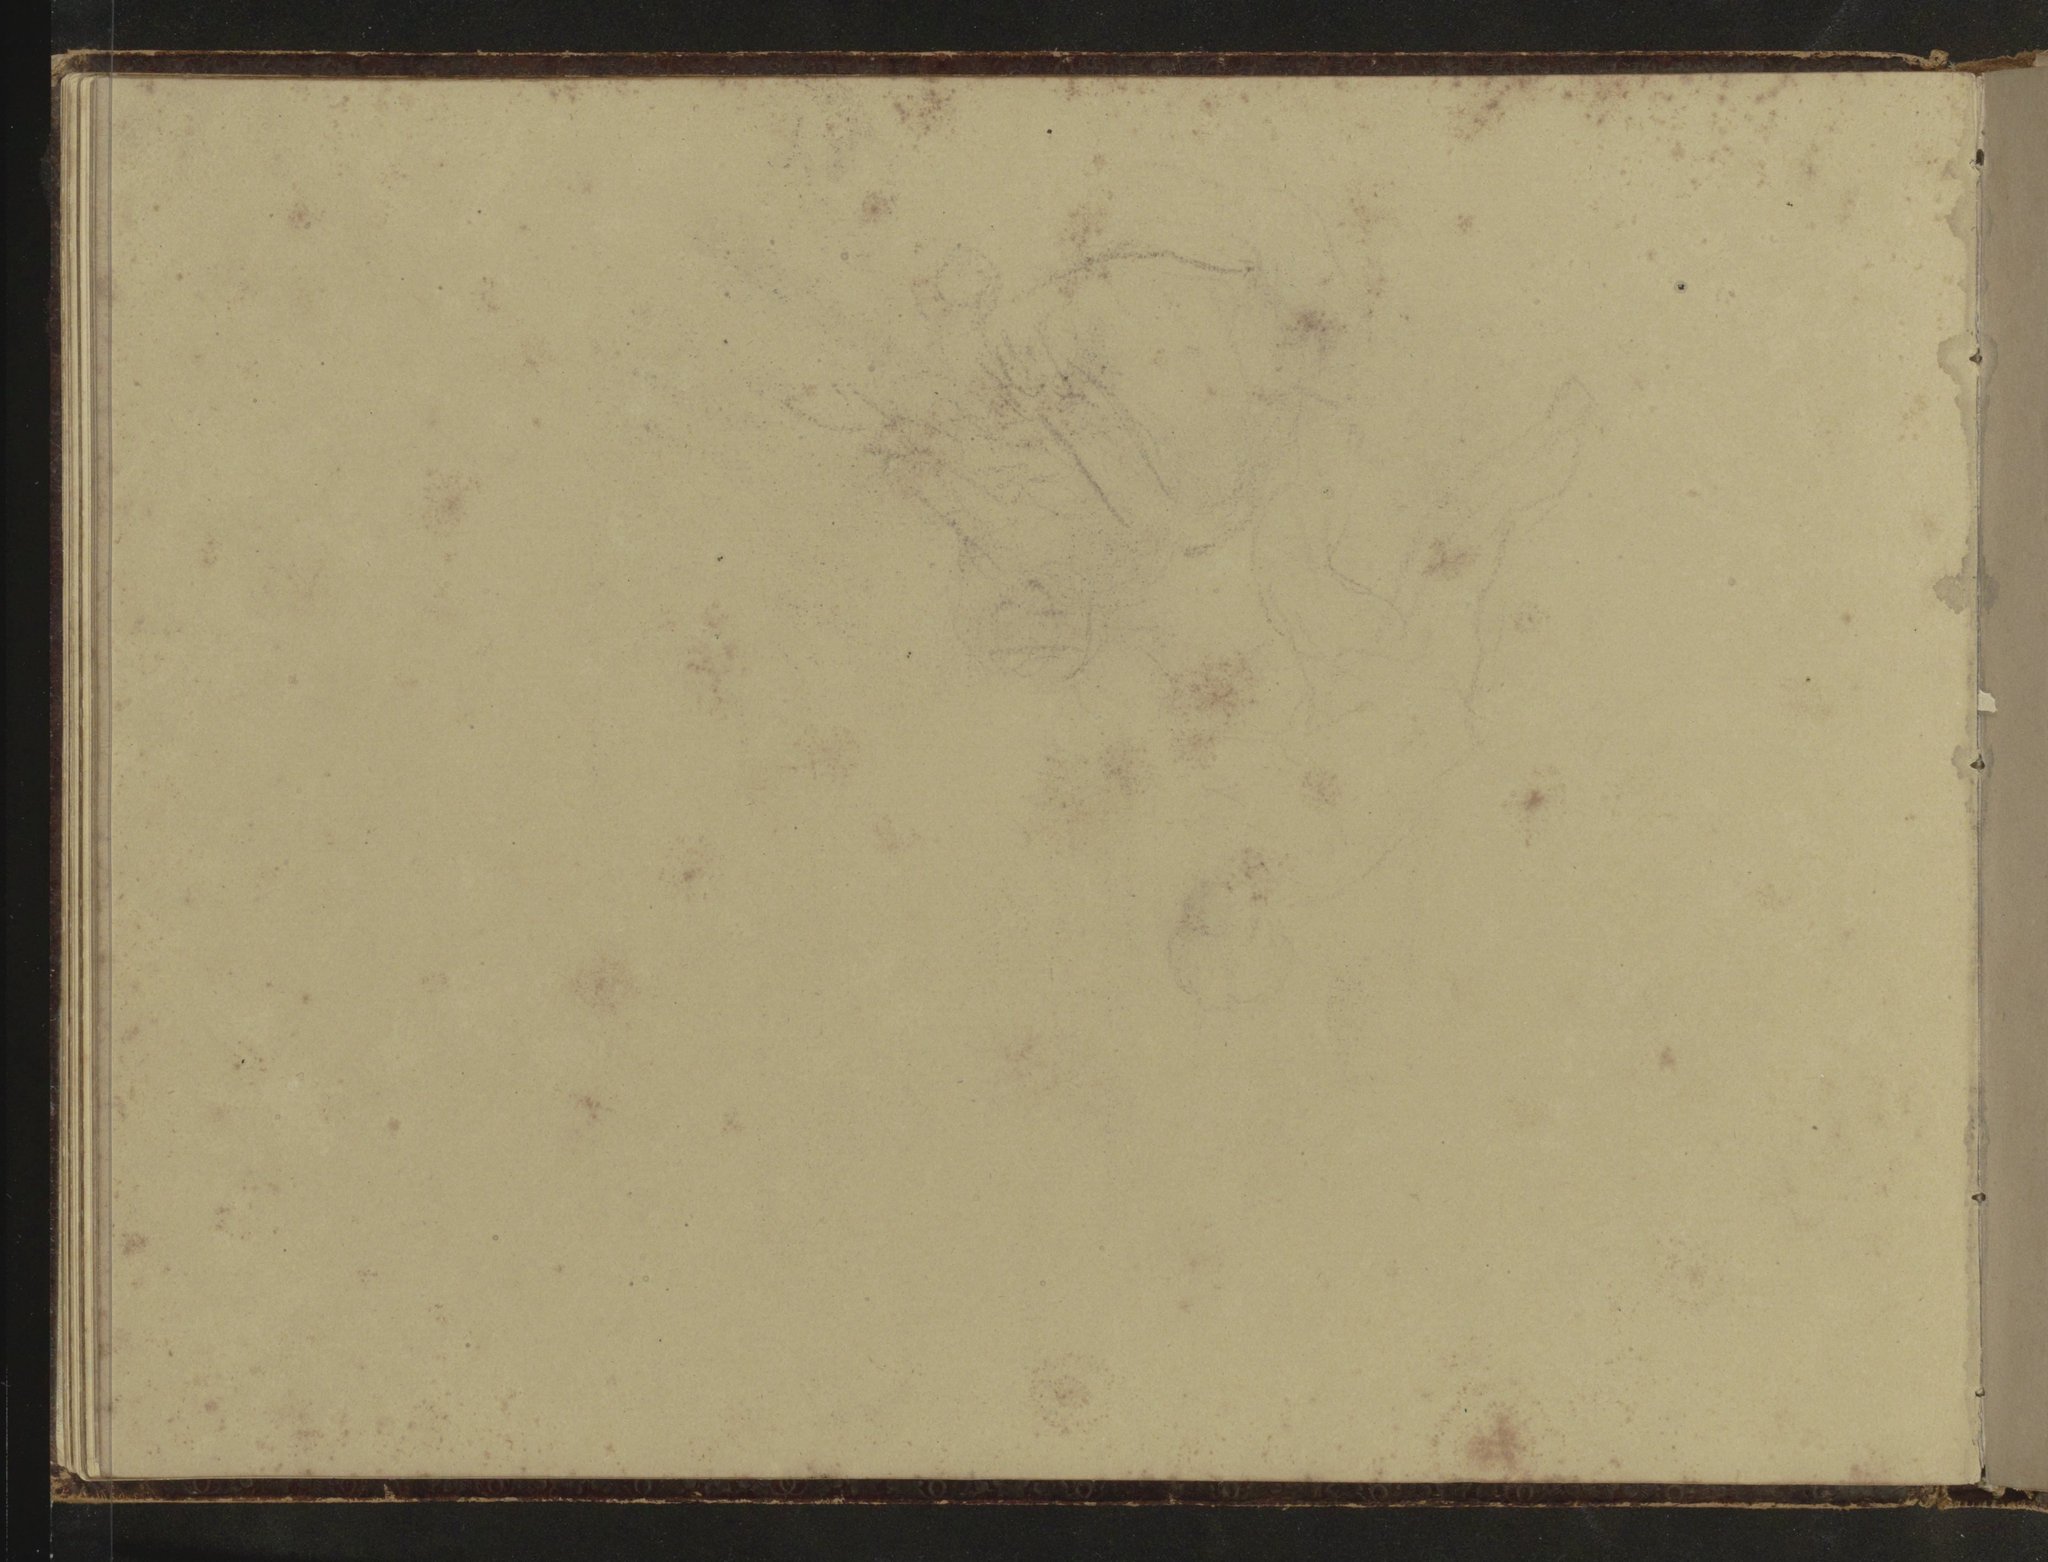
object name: sketchbook leaf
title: Jongen bij een knielend meisje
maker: reinier craeyvanger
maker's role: draughtsman, print maker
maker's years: 1812-1880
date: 1822-1880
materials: charcoal, paper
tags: boy (child between toddler and youth), girl (child between toddler and youth)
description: Blad 28 verso uit een schetsboek met 45 bladen.